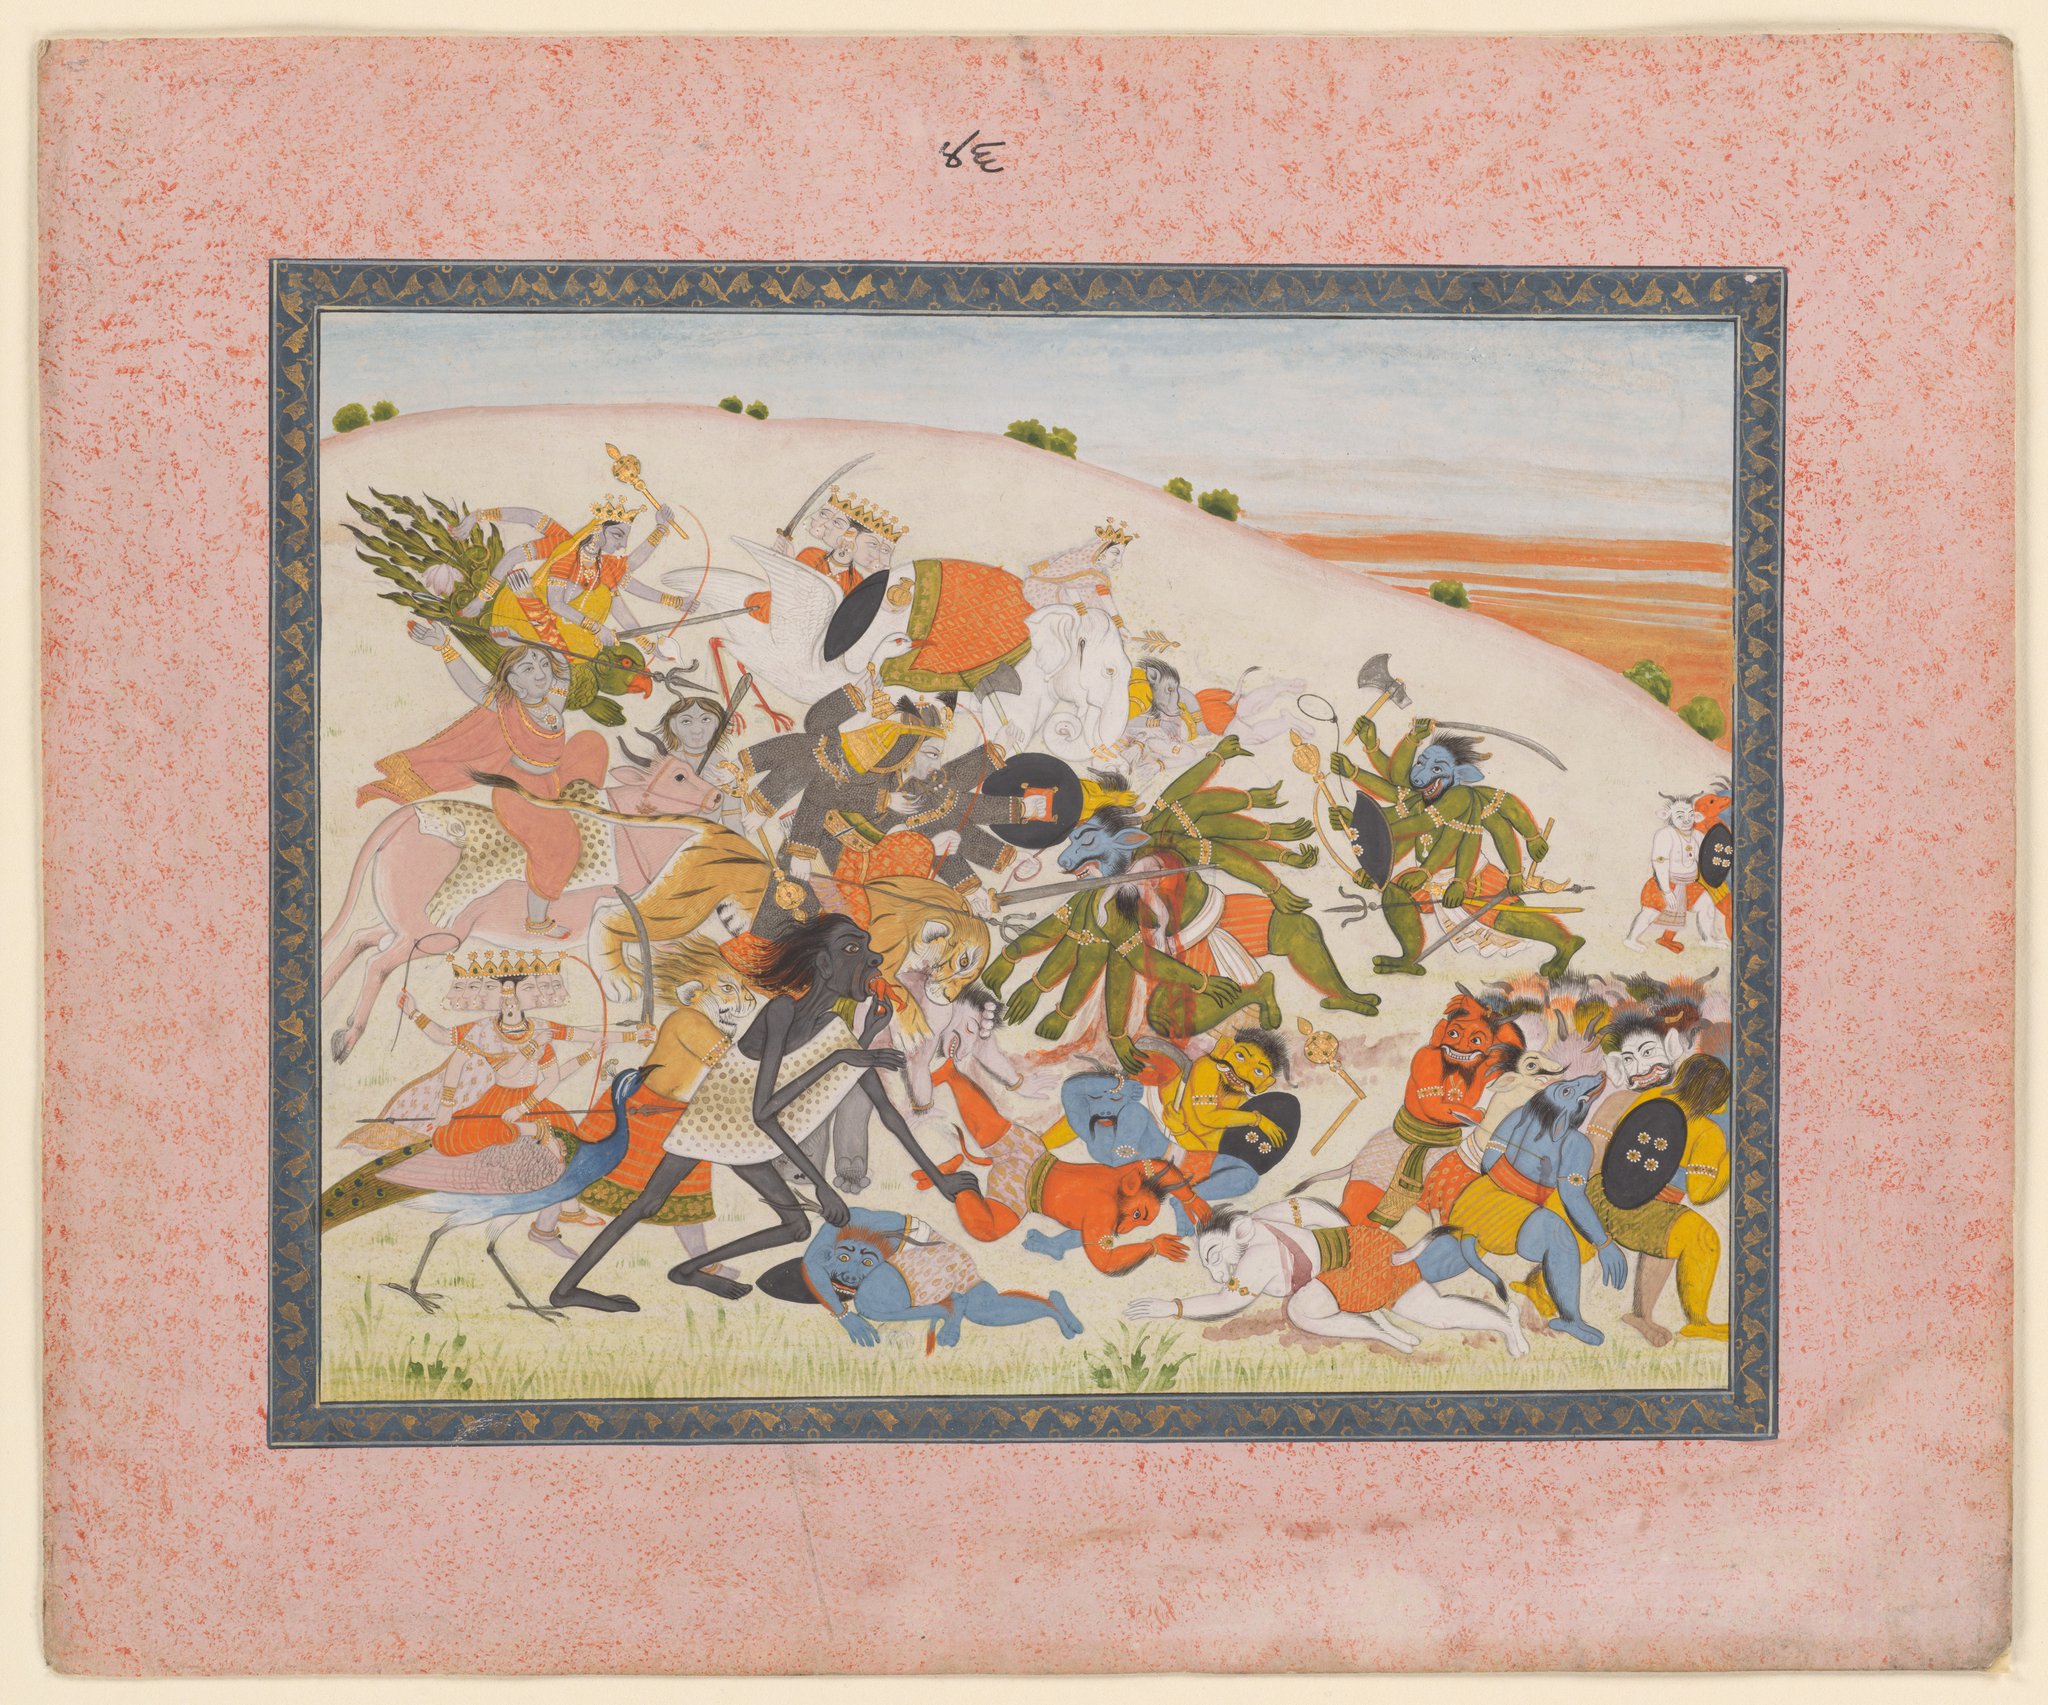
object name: folio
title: Devi vanquishes the demon Nisumbha and his armies; folio from a Devi Mahatmya series.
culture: indian or guler or himachal pradesh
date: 1701-1800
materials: gilt, gold, paper, pigment